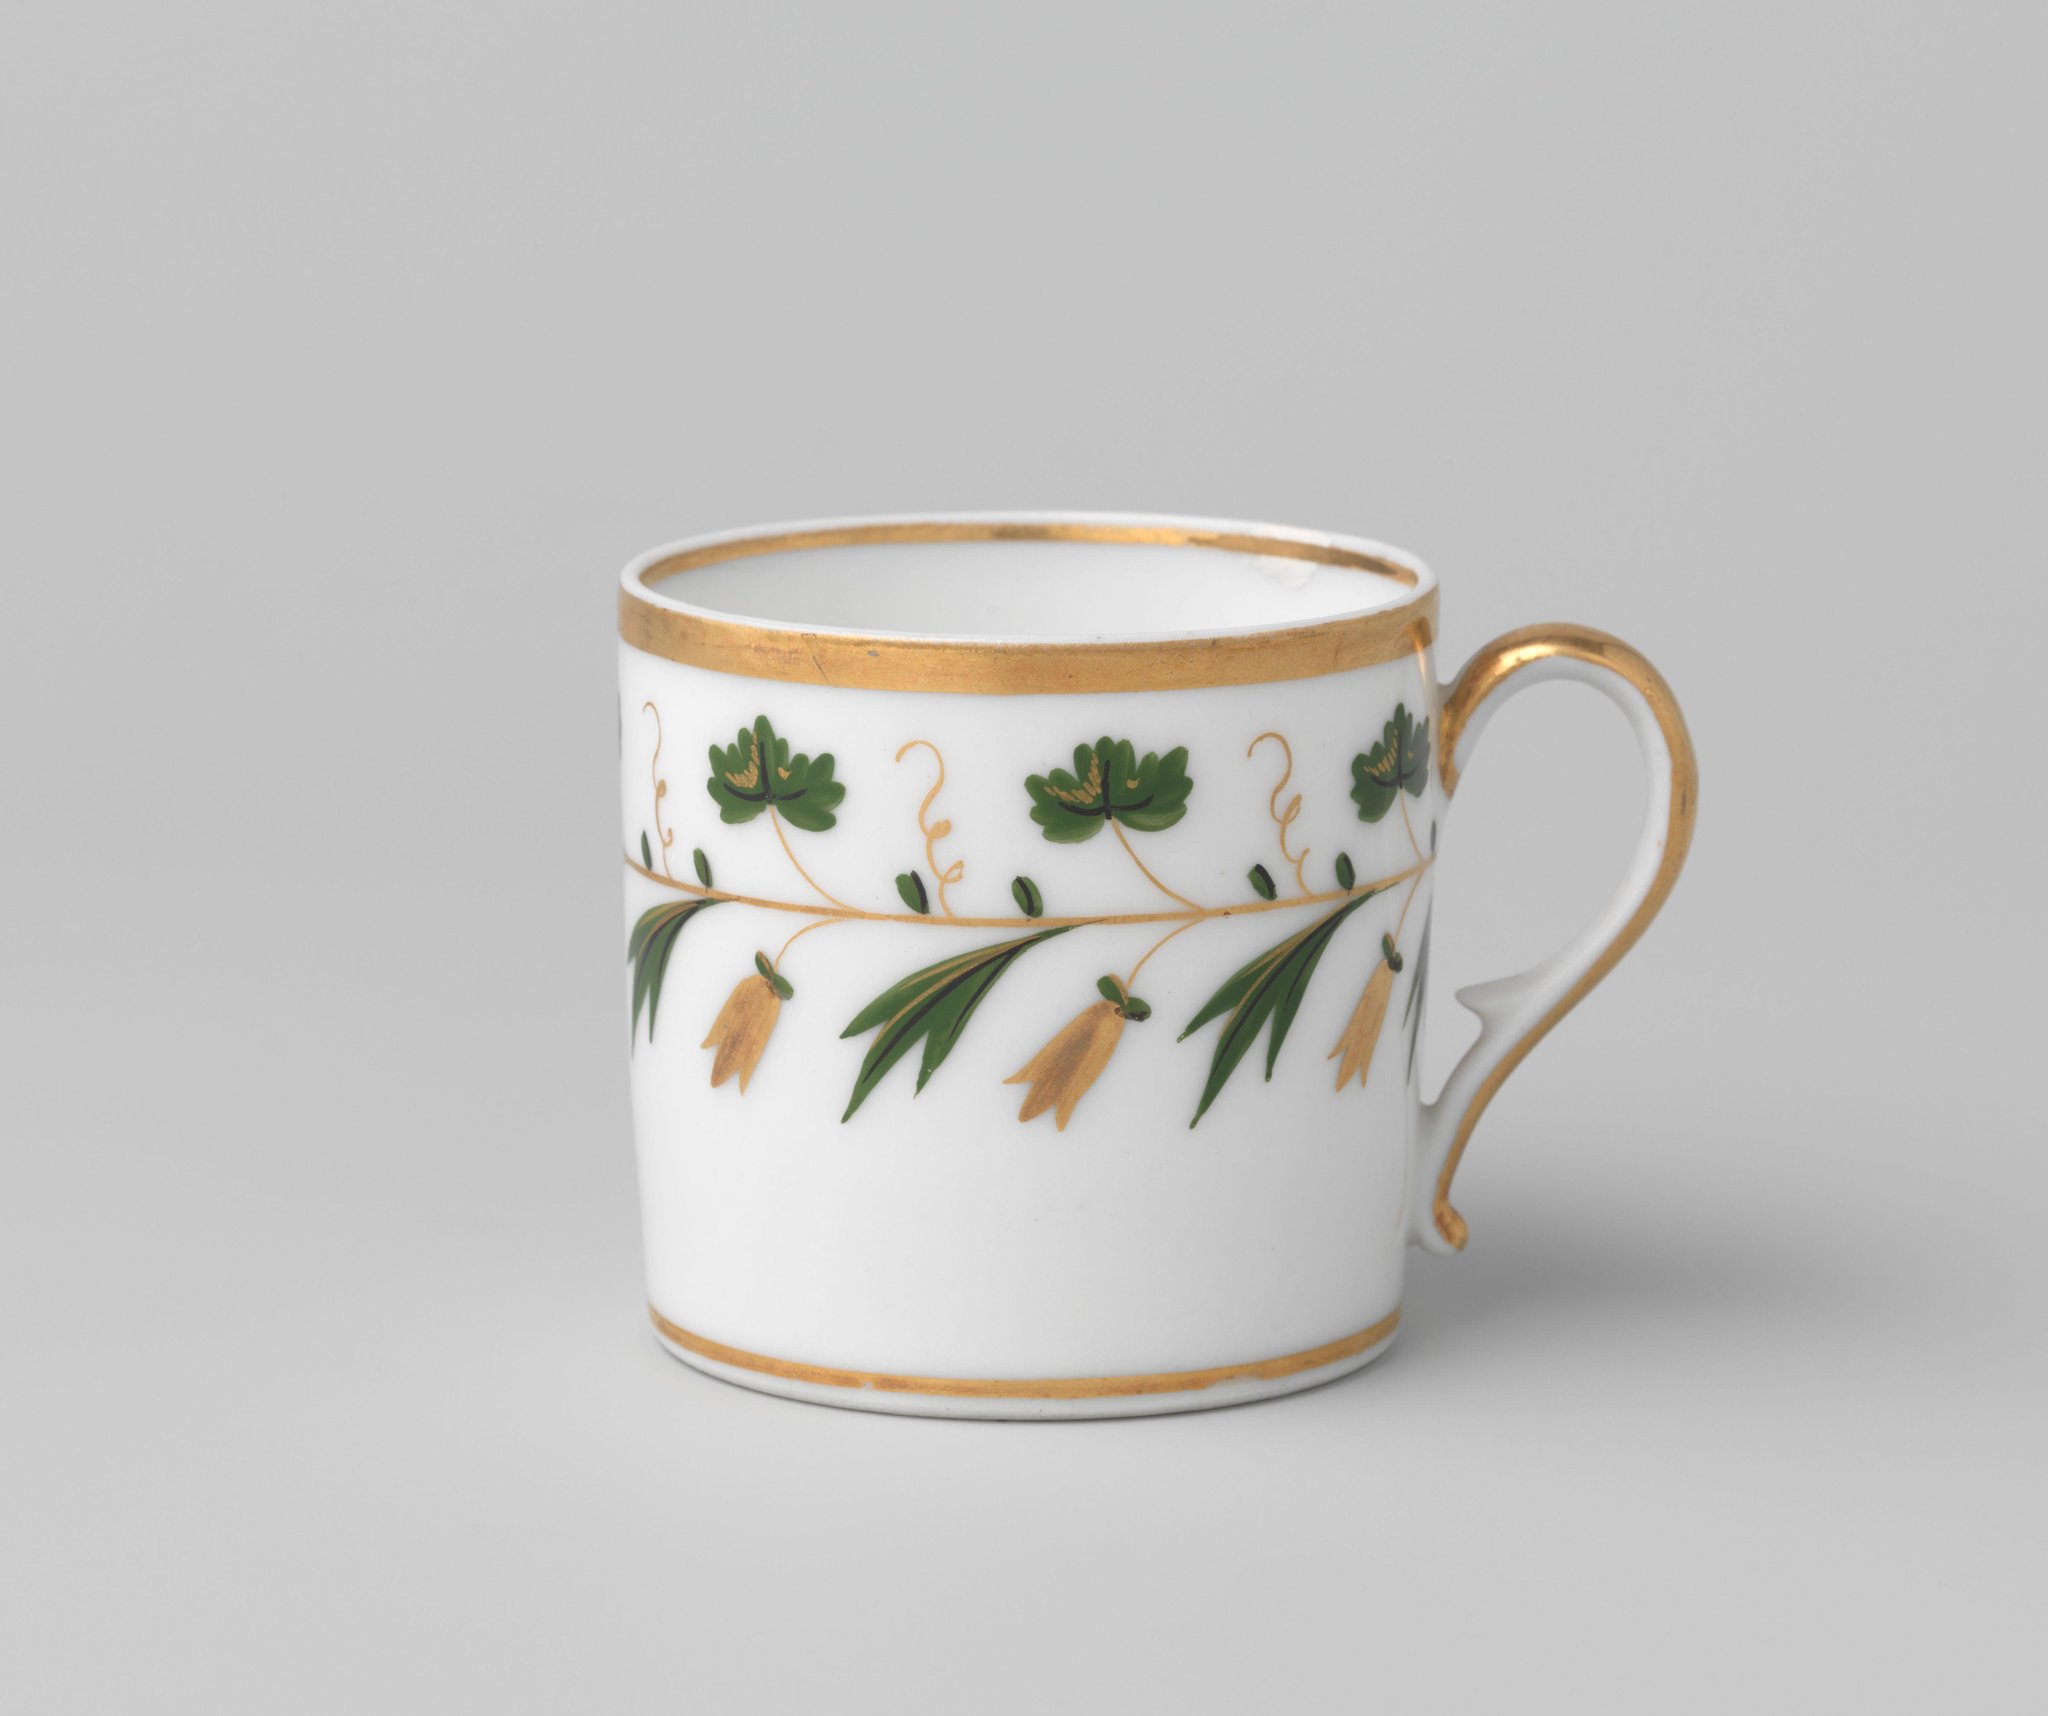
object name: cup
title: Cup with a border of grapevines and flowers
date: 1800-1824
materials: glaze, gold, paint, porcelain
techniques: firing, forming, gilding, turning, vitrification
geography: la courtille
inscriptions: mark: ‘gekruiste pijlen’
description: Kop van porselein met een cilindrische wand en C-vormig oor, beschilderd op het glazuur in groen, zwart en goud. Op de buitenwand een band met aan de ene zijde wijnranken en aan de andere zijde bloemen en bladeren. Gouden rand, voet en oor. Gemerkt op de onderzijde met de gekruiste pijlen.